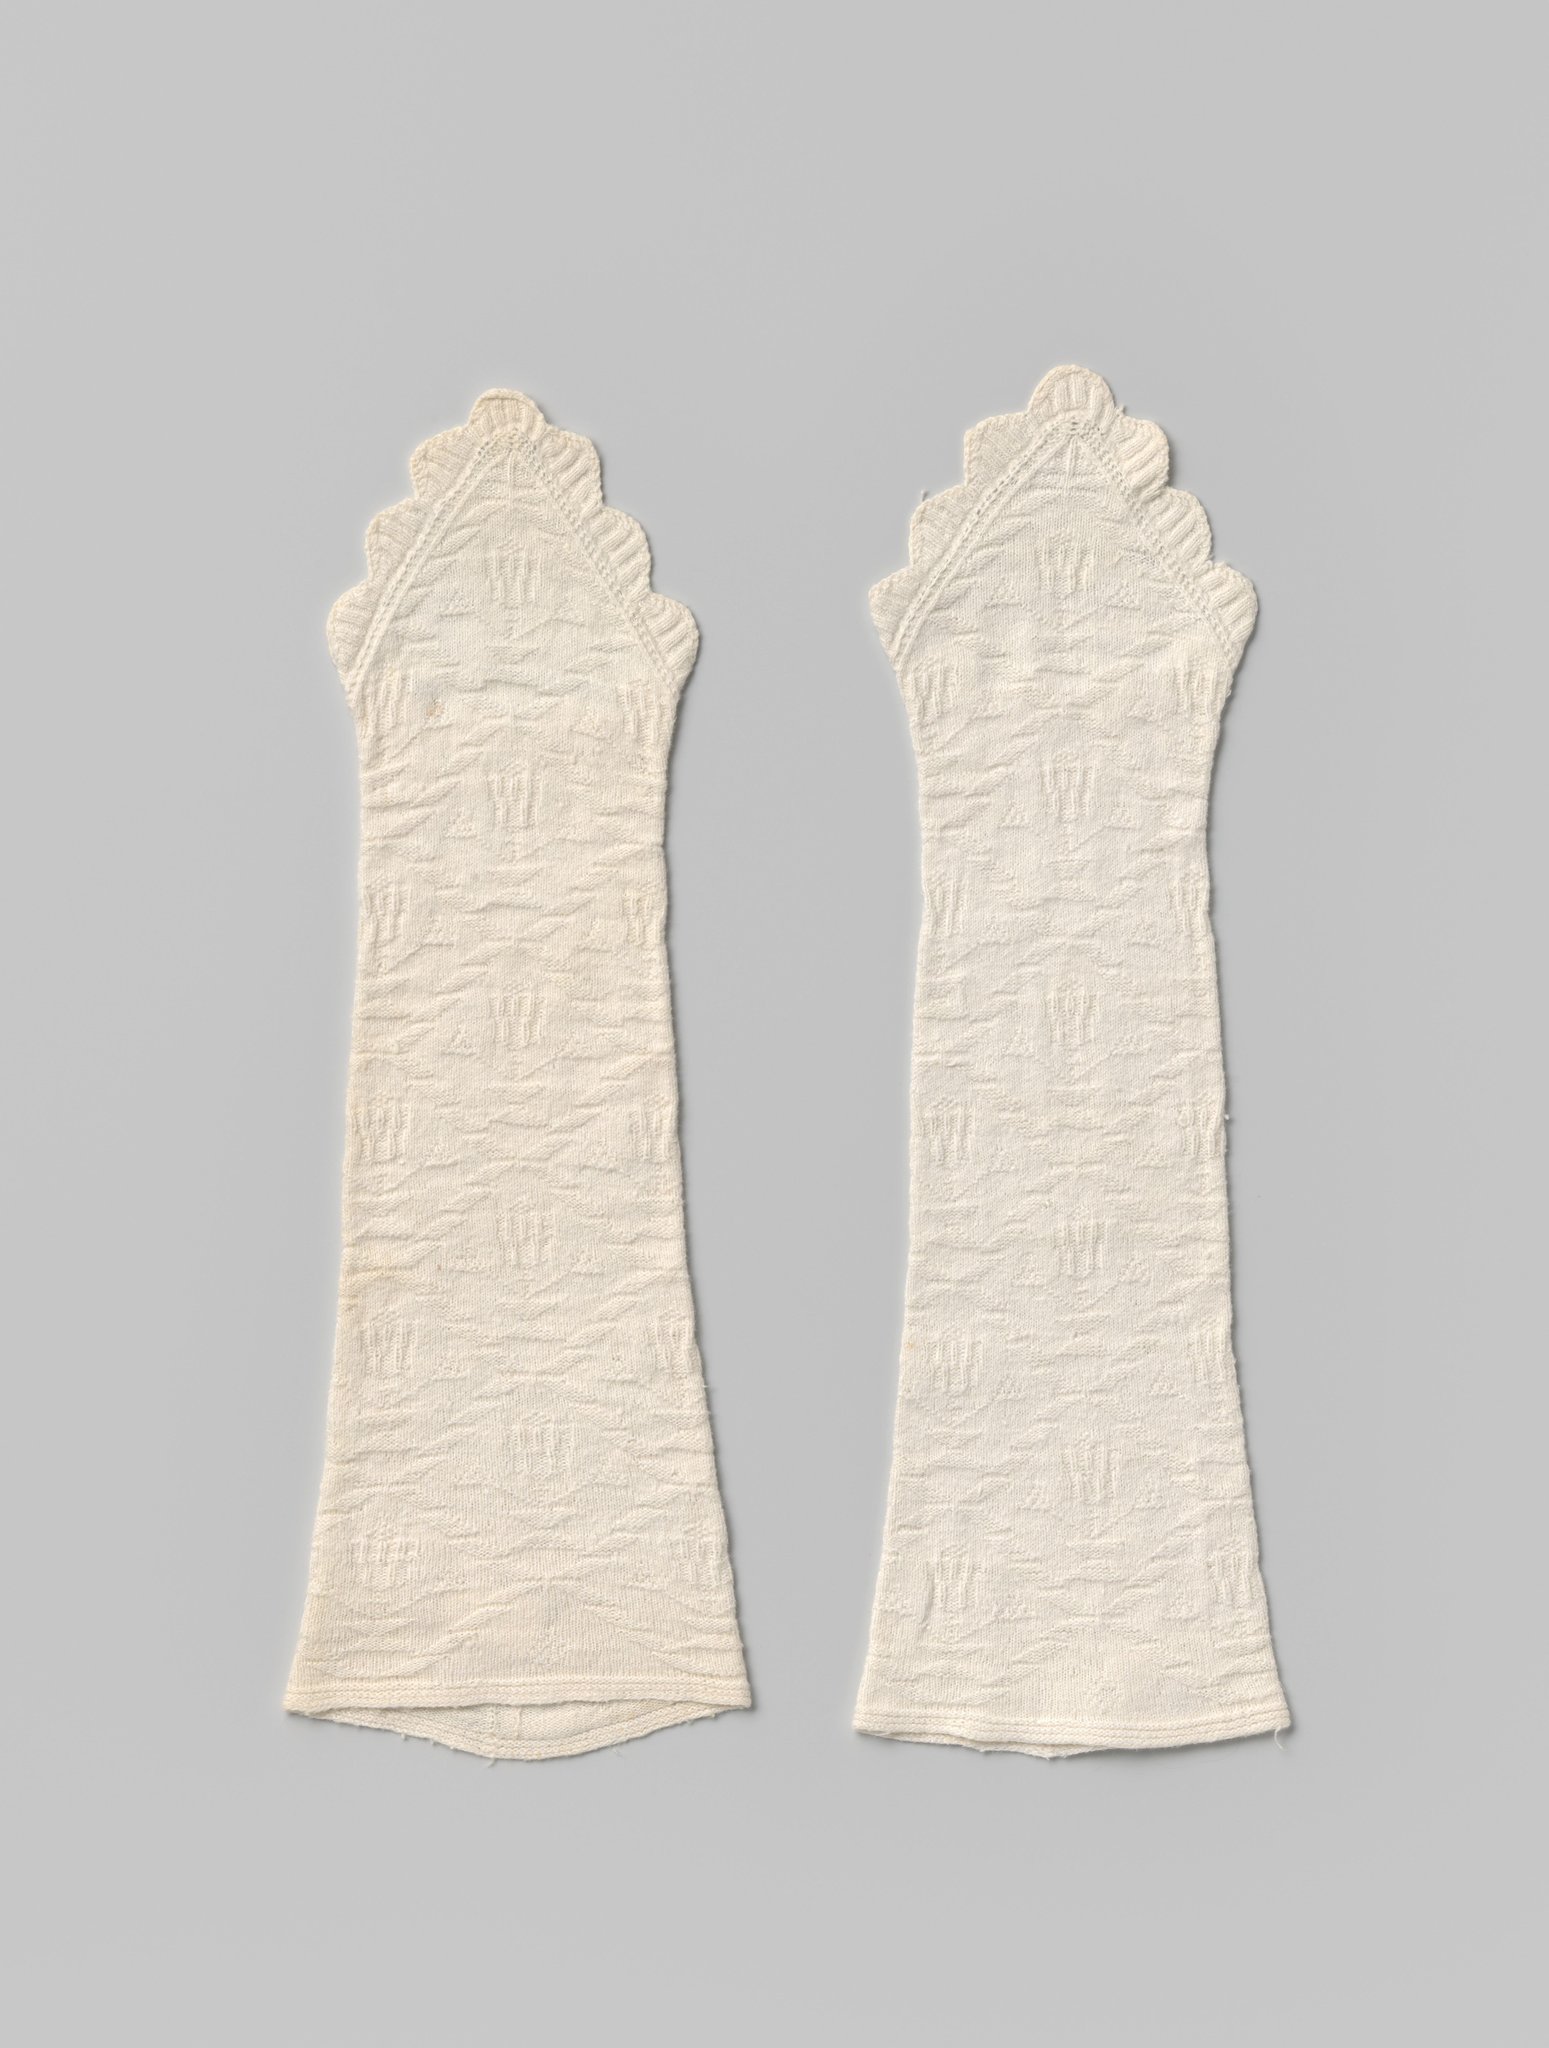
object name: clothing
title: Mitaine van gebreide witte katoen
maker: Anonymous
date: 1700-1750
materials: cotton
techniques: embroidered, knitting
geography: netherlands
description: Mitaines van gebreid wit katoen, met gelijk ingebreid patroon van rasterwerk met grote bloem; het éne gemerkt ivm (of mm?), het andere met I. Model: Ellebooglang. Zonder duimen met driehoekig gedeelte dat over de handrug valt. Hieraan is een rand van schulpen gebreid, Er is één lengtenaad. Breipatroon: Rasterwerk, dat gevormd is van schuin boven elkaar staande dropjes, is telkens gevuld, met een diabolo-vormige vaas, waarin een grote tulp aan korte steel staat, tussen twee blaadjes. De merken zijn in wit in de maasteek opgeborduurd.